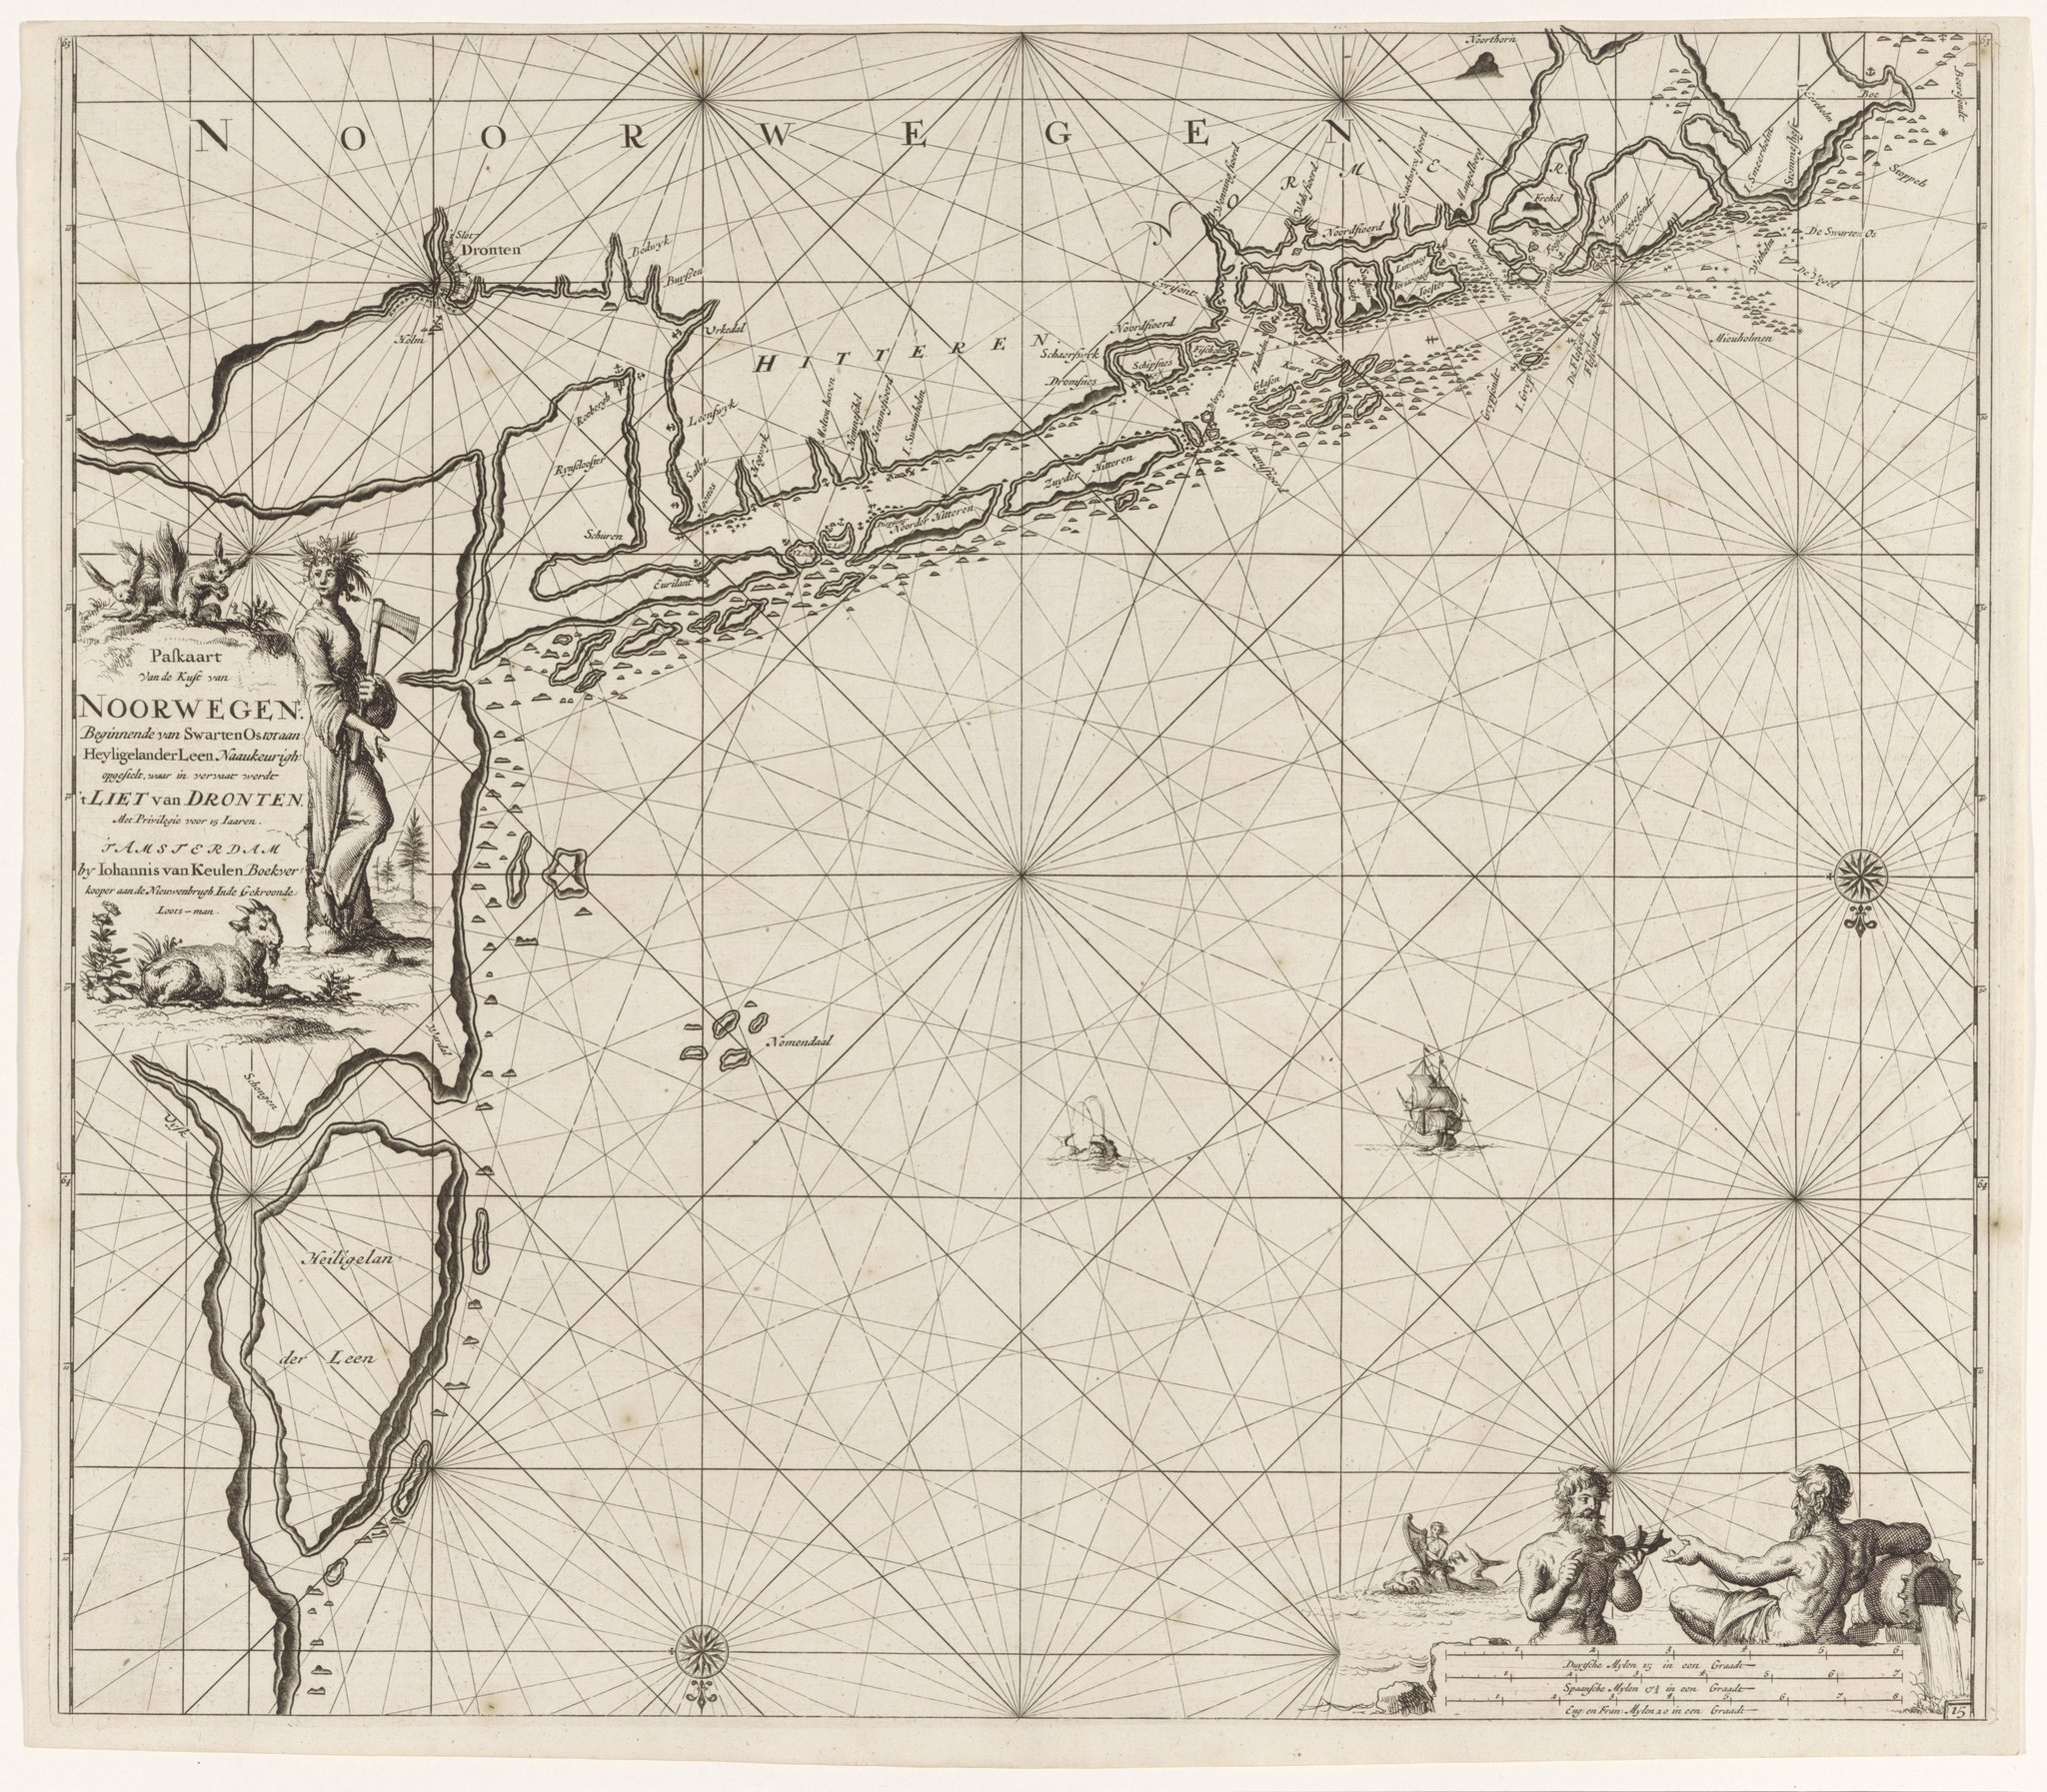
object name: print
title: Paskaart van de Kust van Noorwegen Beginnende van Swarten Os tot aan Heyligerlander Leen Naaukeurigh opgestelt, waar in vervaat werdt 't Liet van Dronten.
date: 1681-1799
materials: paper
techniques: engraving, etching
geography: amsterdam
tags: tools, aids, implements ~ crafts and industries: axe, goat, rodents: squirrel, (story of) arion, swimming mammals: whale, norway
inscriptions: collector's mark: Lugt 2228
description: Paskaart van de kust van Noorwegen in de omgeving van Trondheim, met twee kompasrozen, het Noorden ligt onder. Links een cartouche met de titel en het adres van de uitgever, waarbij een geit, een eekhoorn en een vrouw, getooid met een krans van korenaren en in haar hand een bijl. Rechtsonder twee zeegoden, waarvan er een een schepenkroon in de hand heeft. op de achtergrond Arion op een dolfijn. Onder het tafereel de schaalverdeling, weergegeven in Duitse, Spaanse en Engelse of Franse mijlen (schaal: c. 1:300.000).